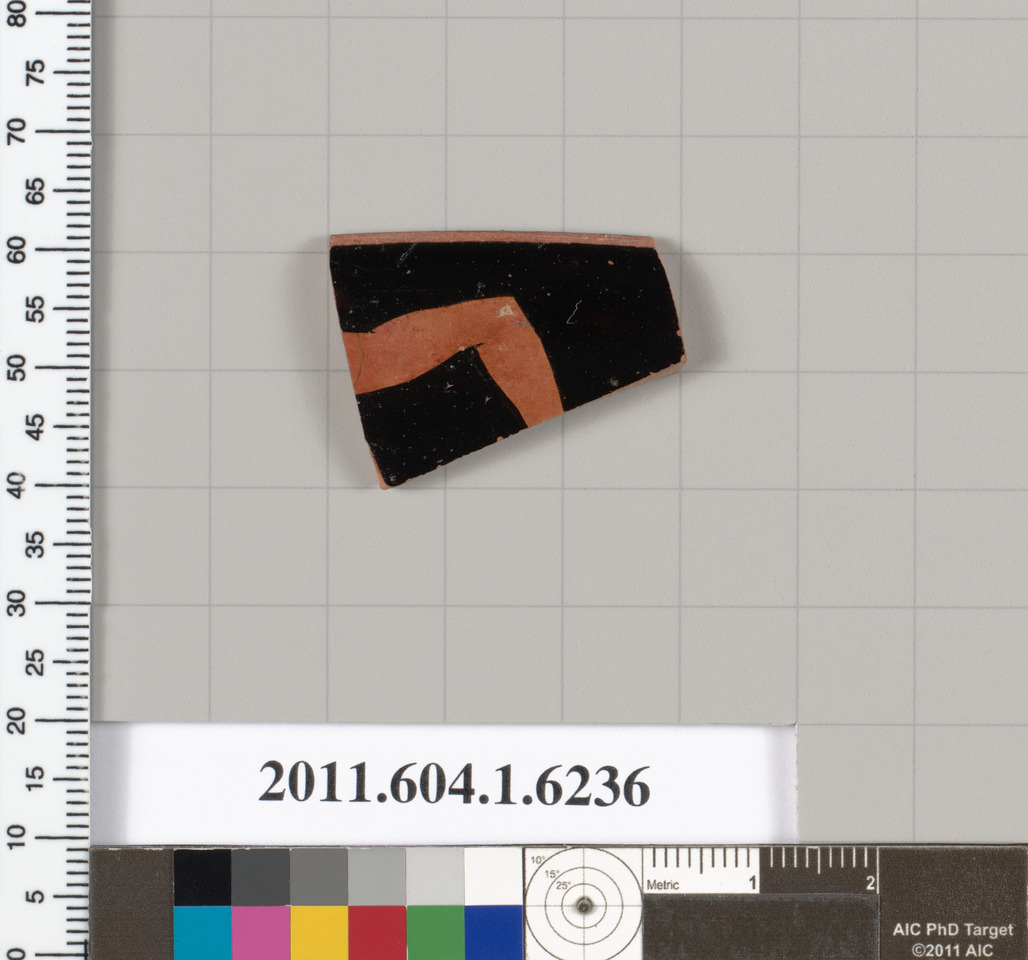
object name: kylix fragment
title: Terracotta rim fragment of a kylix (drinking cup)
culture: greek, attic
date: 520-510 BCE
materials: terracotta